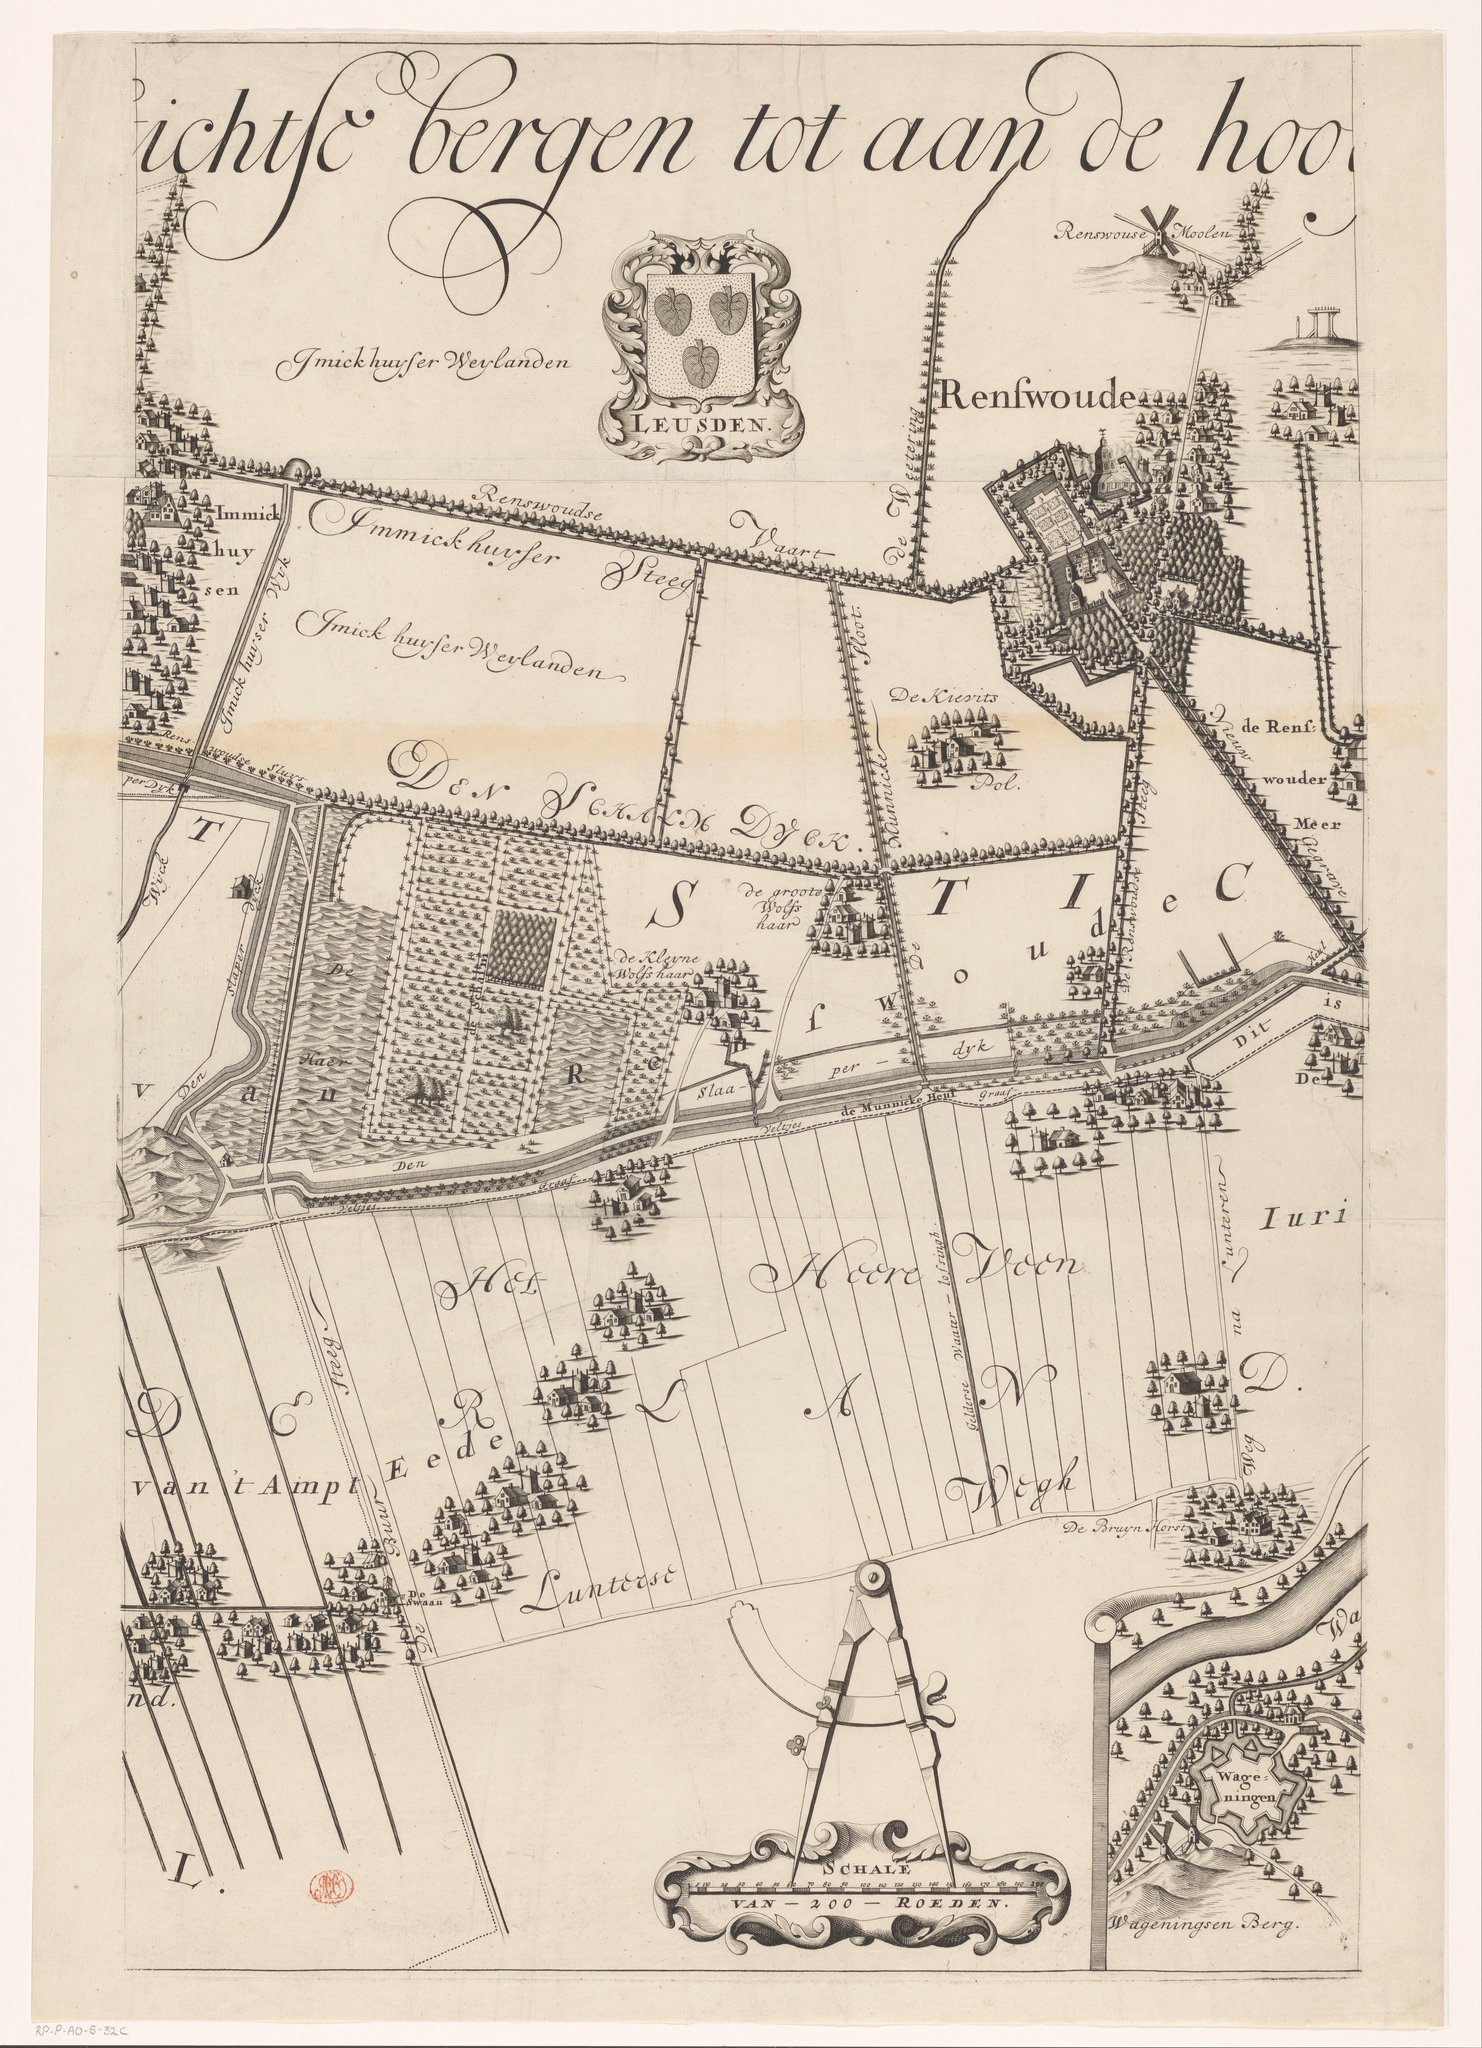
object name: print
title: Caarte vanden Slaperdijk streckende vande Stichtse bergen tot aan de hoogte van Gelderland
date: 1705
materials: paper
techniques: engraving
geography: utrecht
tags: coat of arms (as symbol of the state, etc.), maps of separate countries or regions, dikes, levee, gelderland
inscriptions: collector's mark: Lugt 2228, collector's mark: Lugt 195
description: Derde deel van een kaart van de Slaperdijk van de Utrechtse Heuvelrug tot aan de dekzandruggen van de Gelderse Vallei.